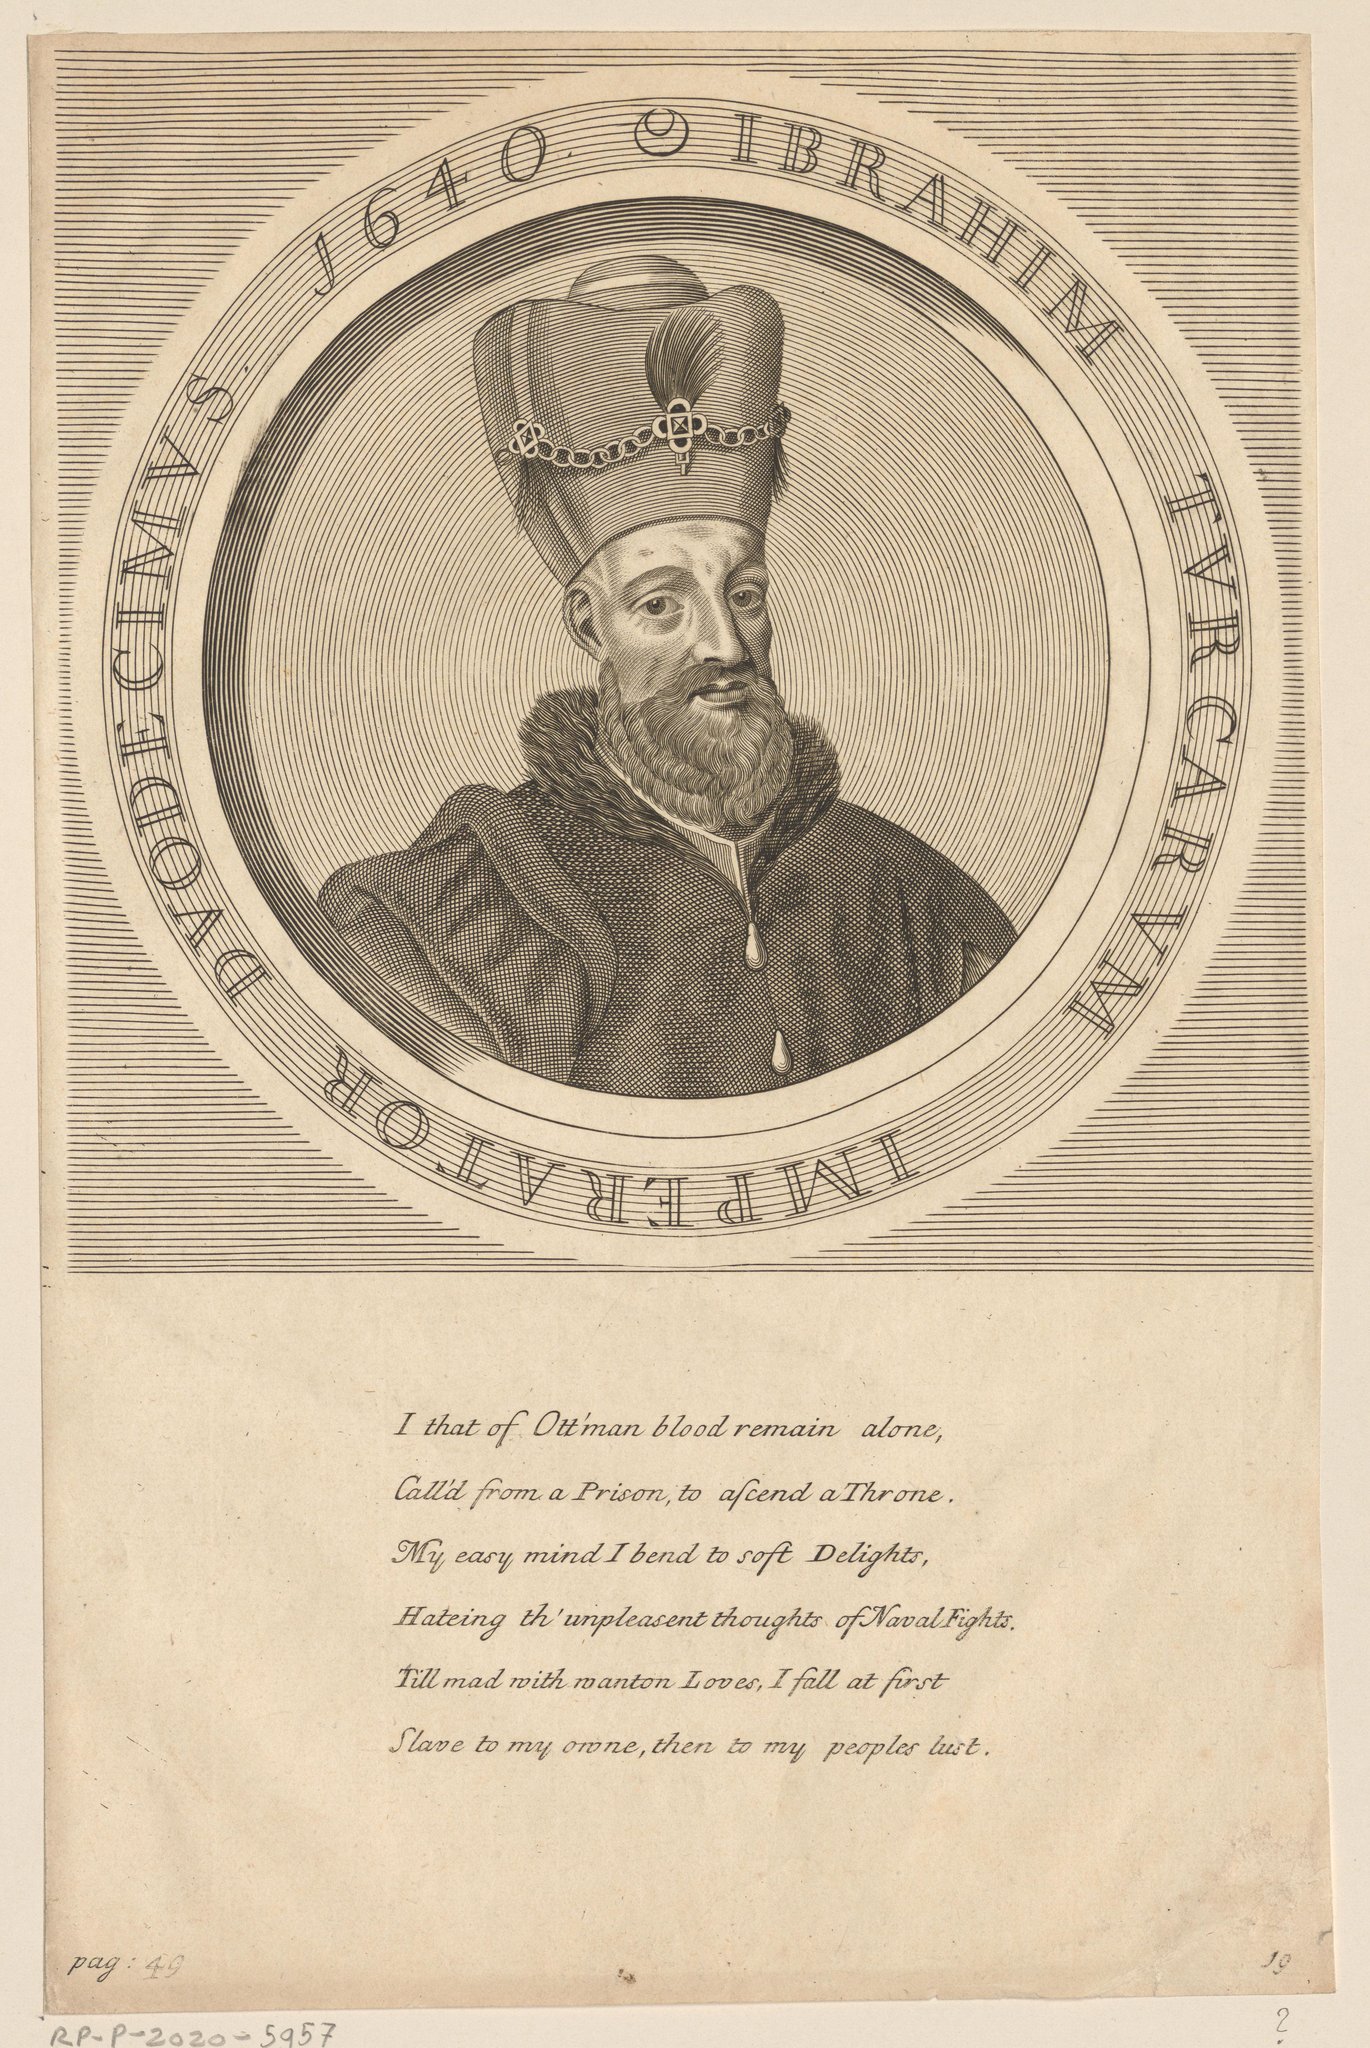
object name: print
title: Portret van Ibrahim I, sultan van Turkije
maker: Anonymous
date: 1650-1749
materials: paper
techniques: engraving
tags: historical persons, ruler, sovereign